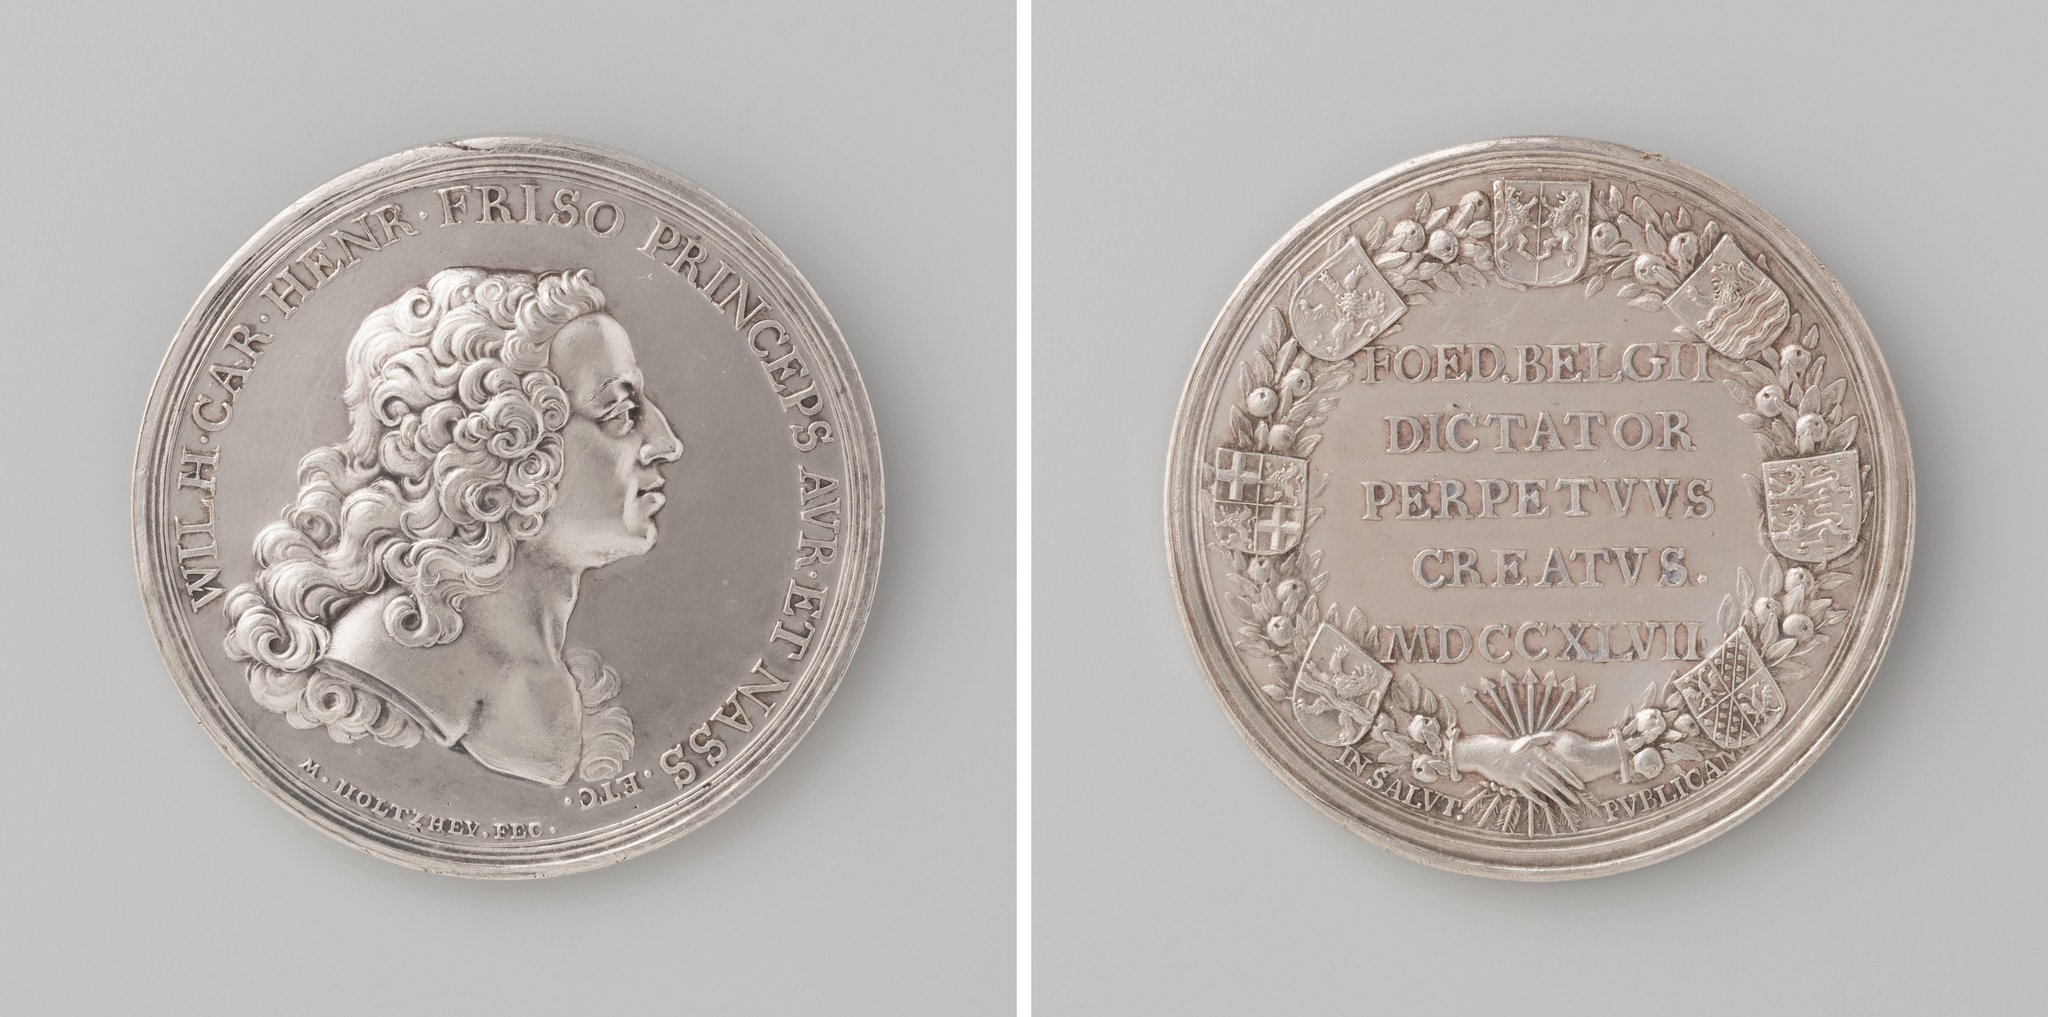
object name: history medal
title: Verheffing van de prins van Oranje tot stadhouder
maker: martinus holtzhey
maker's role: medailleur, muntmaker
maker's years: 1697-1764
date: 1747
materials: silver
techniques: striking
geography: amsterdam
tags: the hague, willem iv (prins van oranje-nassau)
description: Zilveren penning. Voorzijde: borststuk man binnen omschrift. Keerzijde: opschrift binnen oranjekrans met zeven wapenschilden erin vervlochten en uitlopend in twee ineen geslagen handen, die pijlenbundel vasthouden boven opschrift